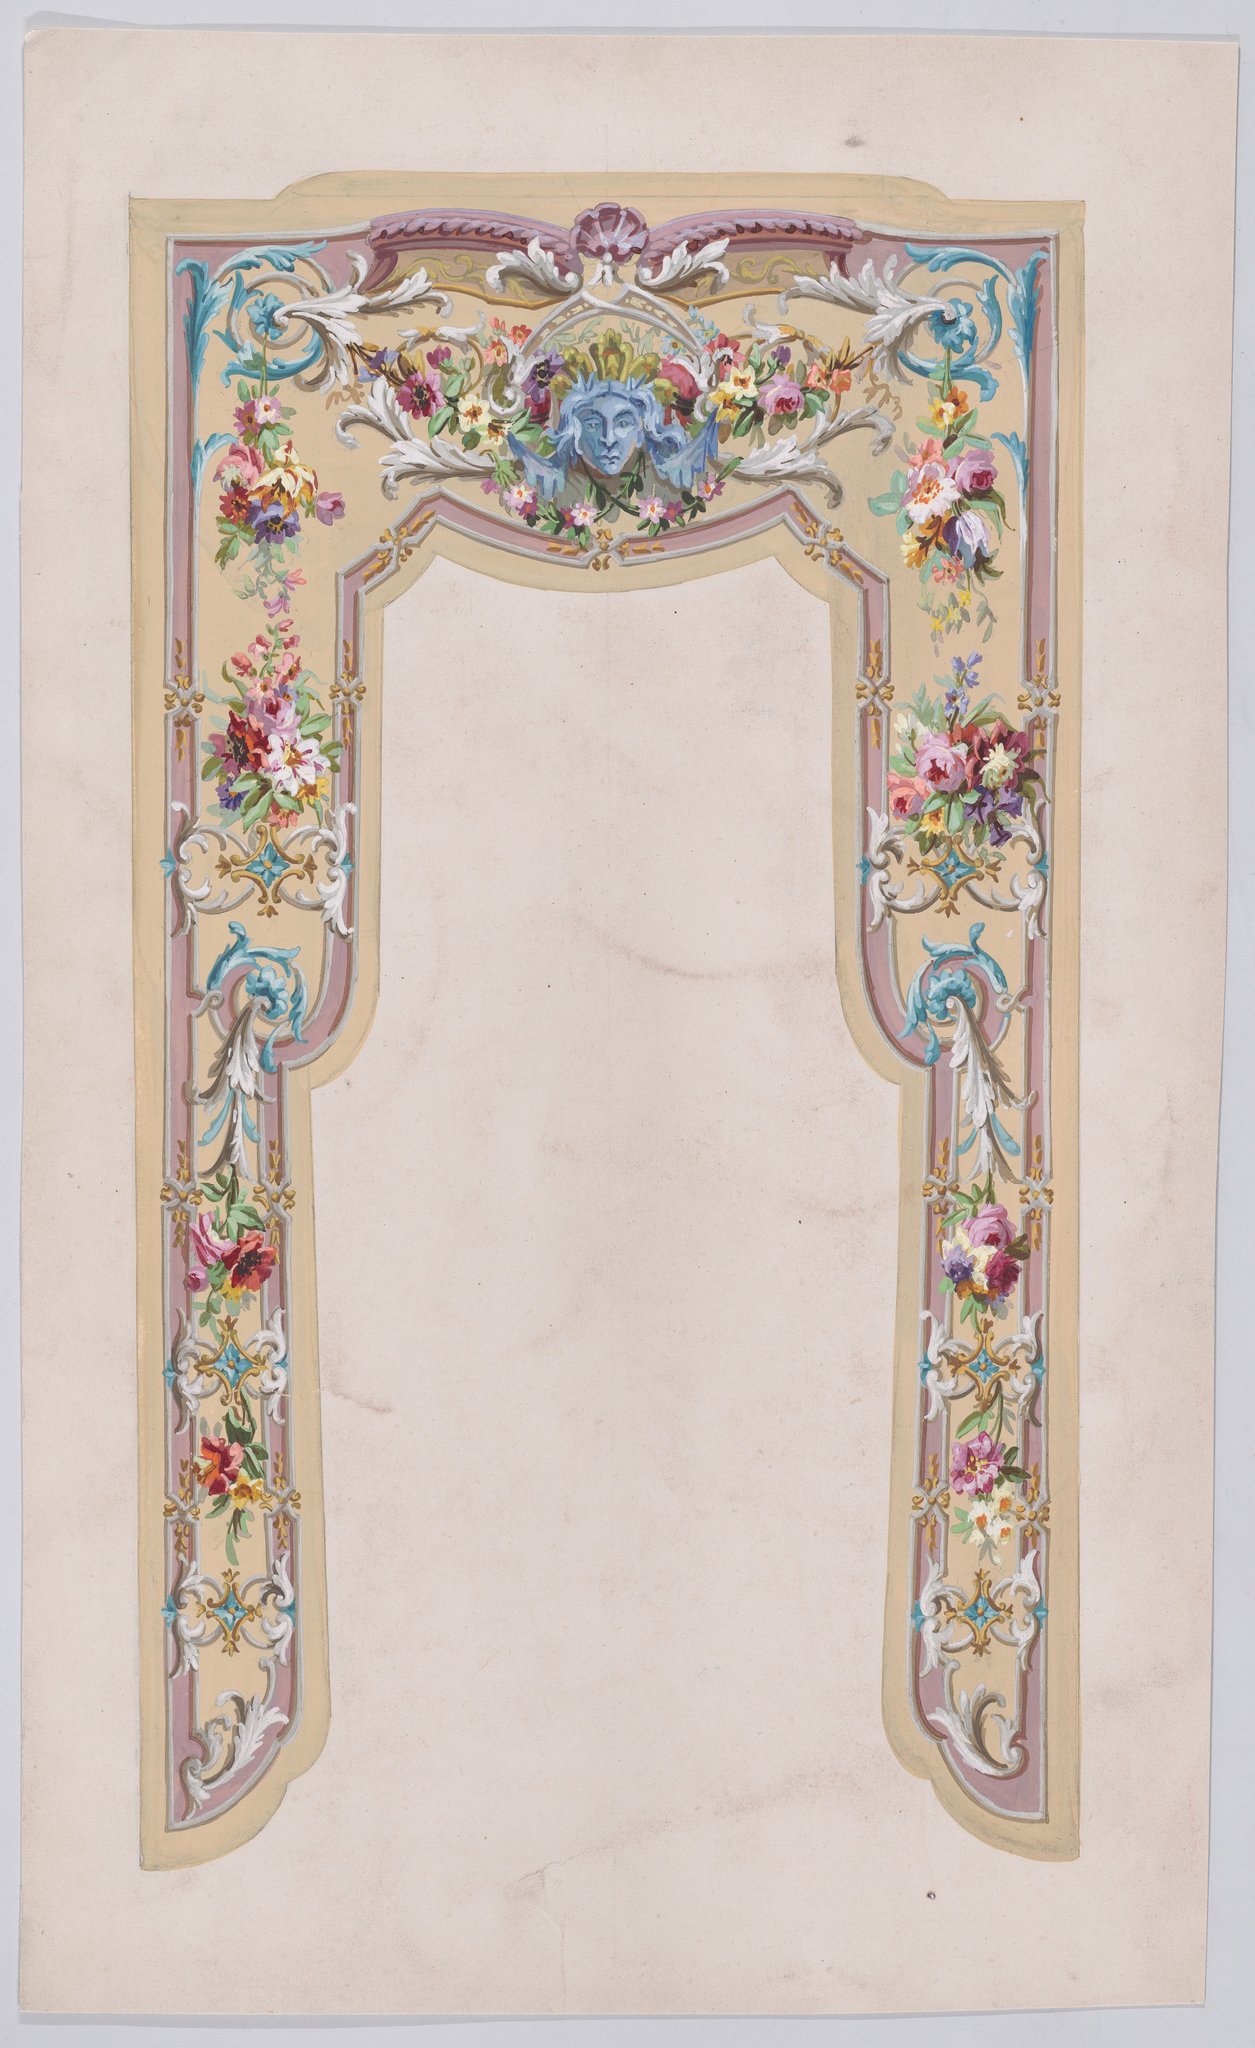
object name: drawing ornament architecture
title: Design for a Valance with a Grotesque Motif and Thin Garlands of Flowers and Leaves with a Scrolling Frame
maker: anonymous, french, 19th century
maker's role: designer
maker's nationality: french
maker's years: 1800-1900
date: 1870-1900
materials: watercolor